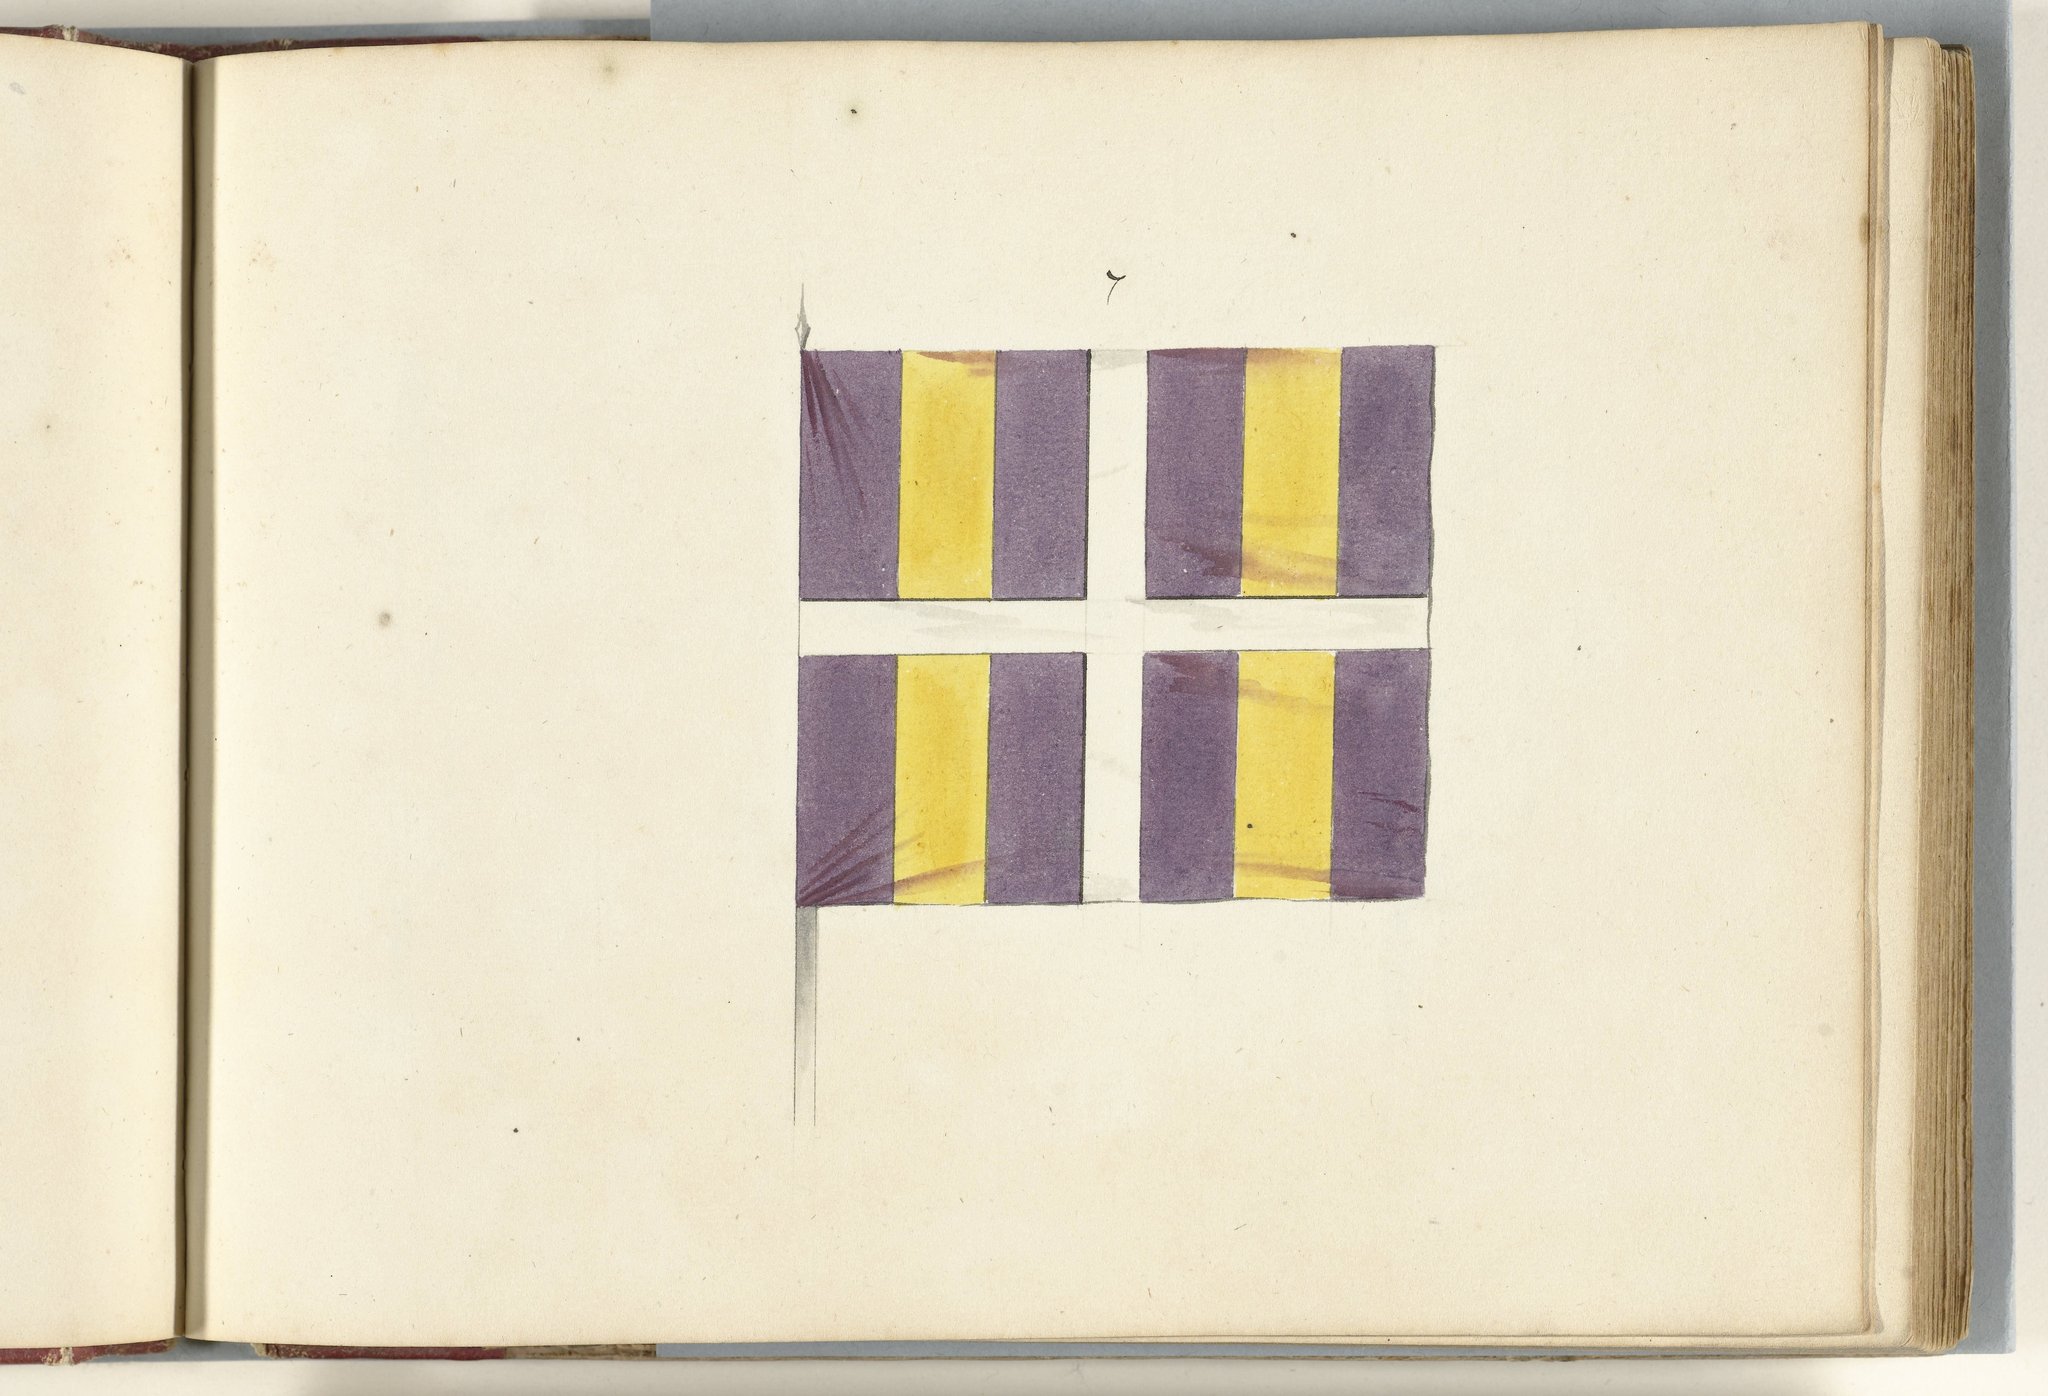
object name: drawing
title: Frans vaandel veroverd bij Dendermonde, 1706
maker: Anonymous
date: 1713-1720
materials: paper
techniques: drawing, writing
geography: northern netherlands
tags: (military) flags and standards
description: Frans vaandel veroverd bij Dendermonde in 1706. In het boek met tekeningen van Franse vaandels, standaarden en pauken, veroverd tijdens de Spaanse Successieoorlog (1701-1713).